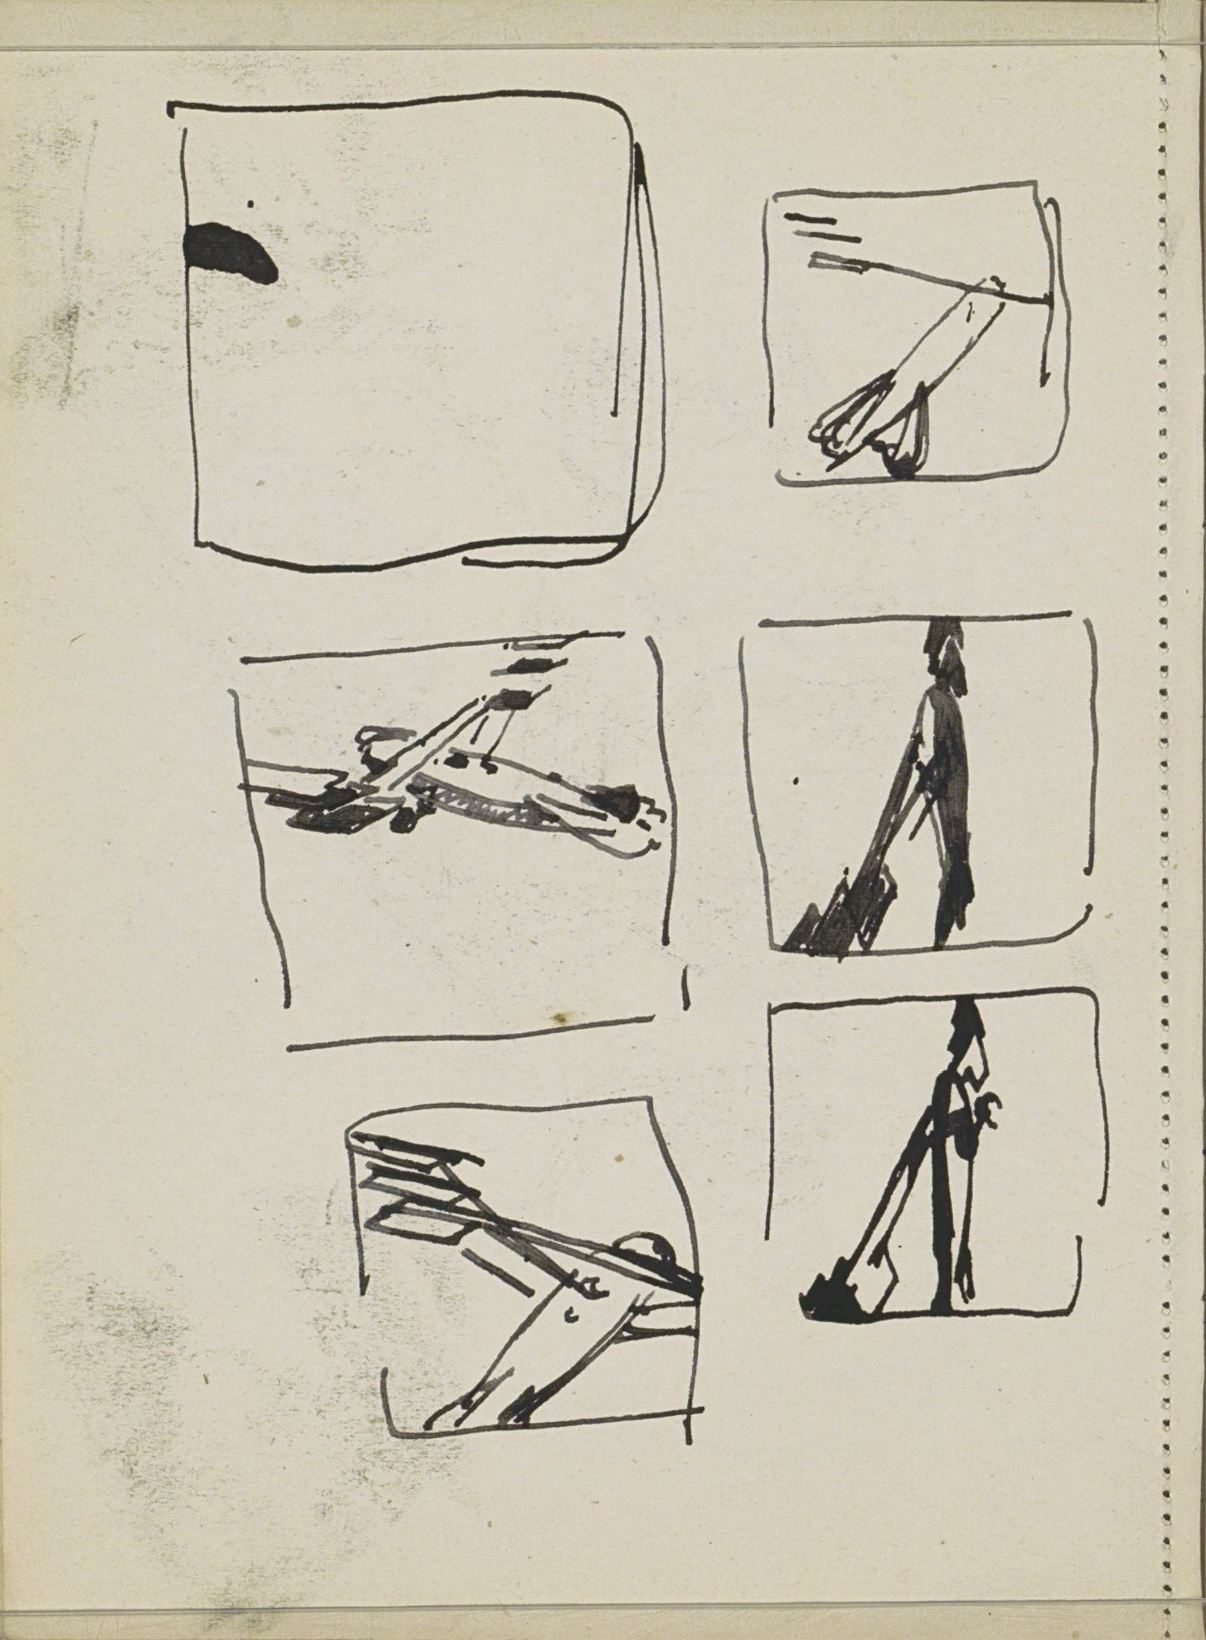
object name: sketchbook leaf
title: Studies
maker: reijer stolk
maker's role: draughtsman, print maker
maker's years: 1896-1945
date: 1906-1945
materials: ink, paper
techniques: pen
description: Mogelijk vliegtuigen. Blad 4 verso uit een schetsboek met 53 bladen.